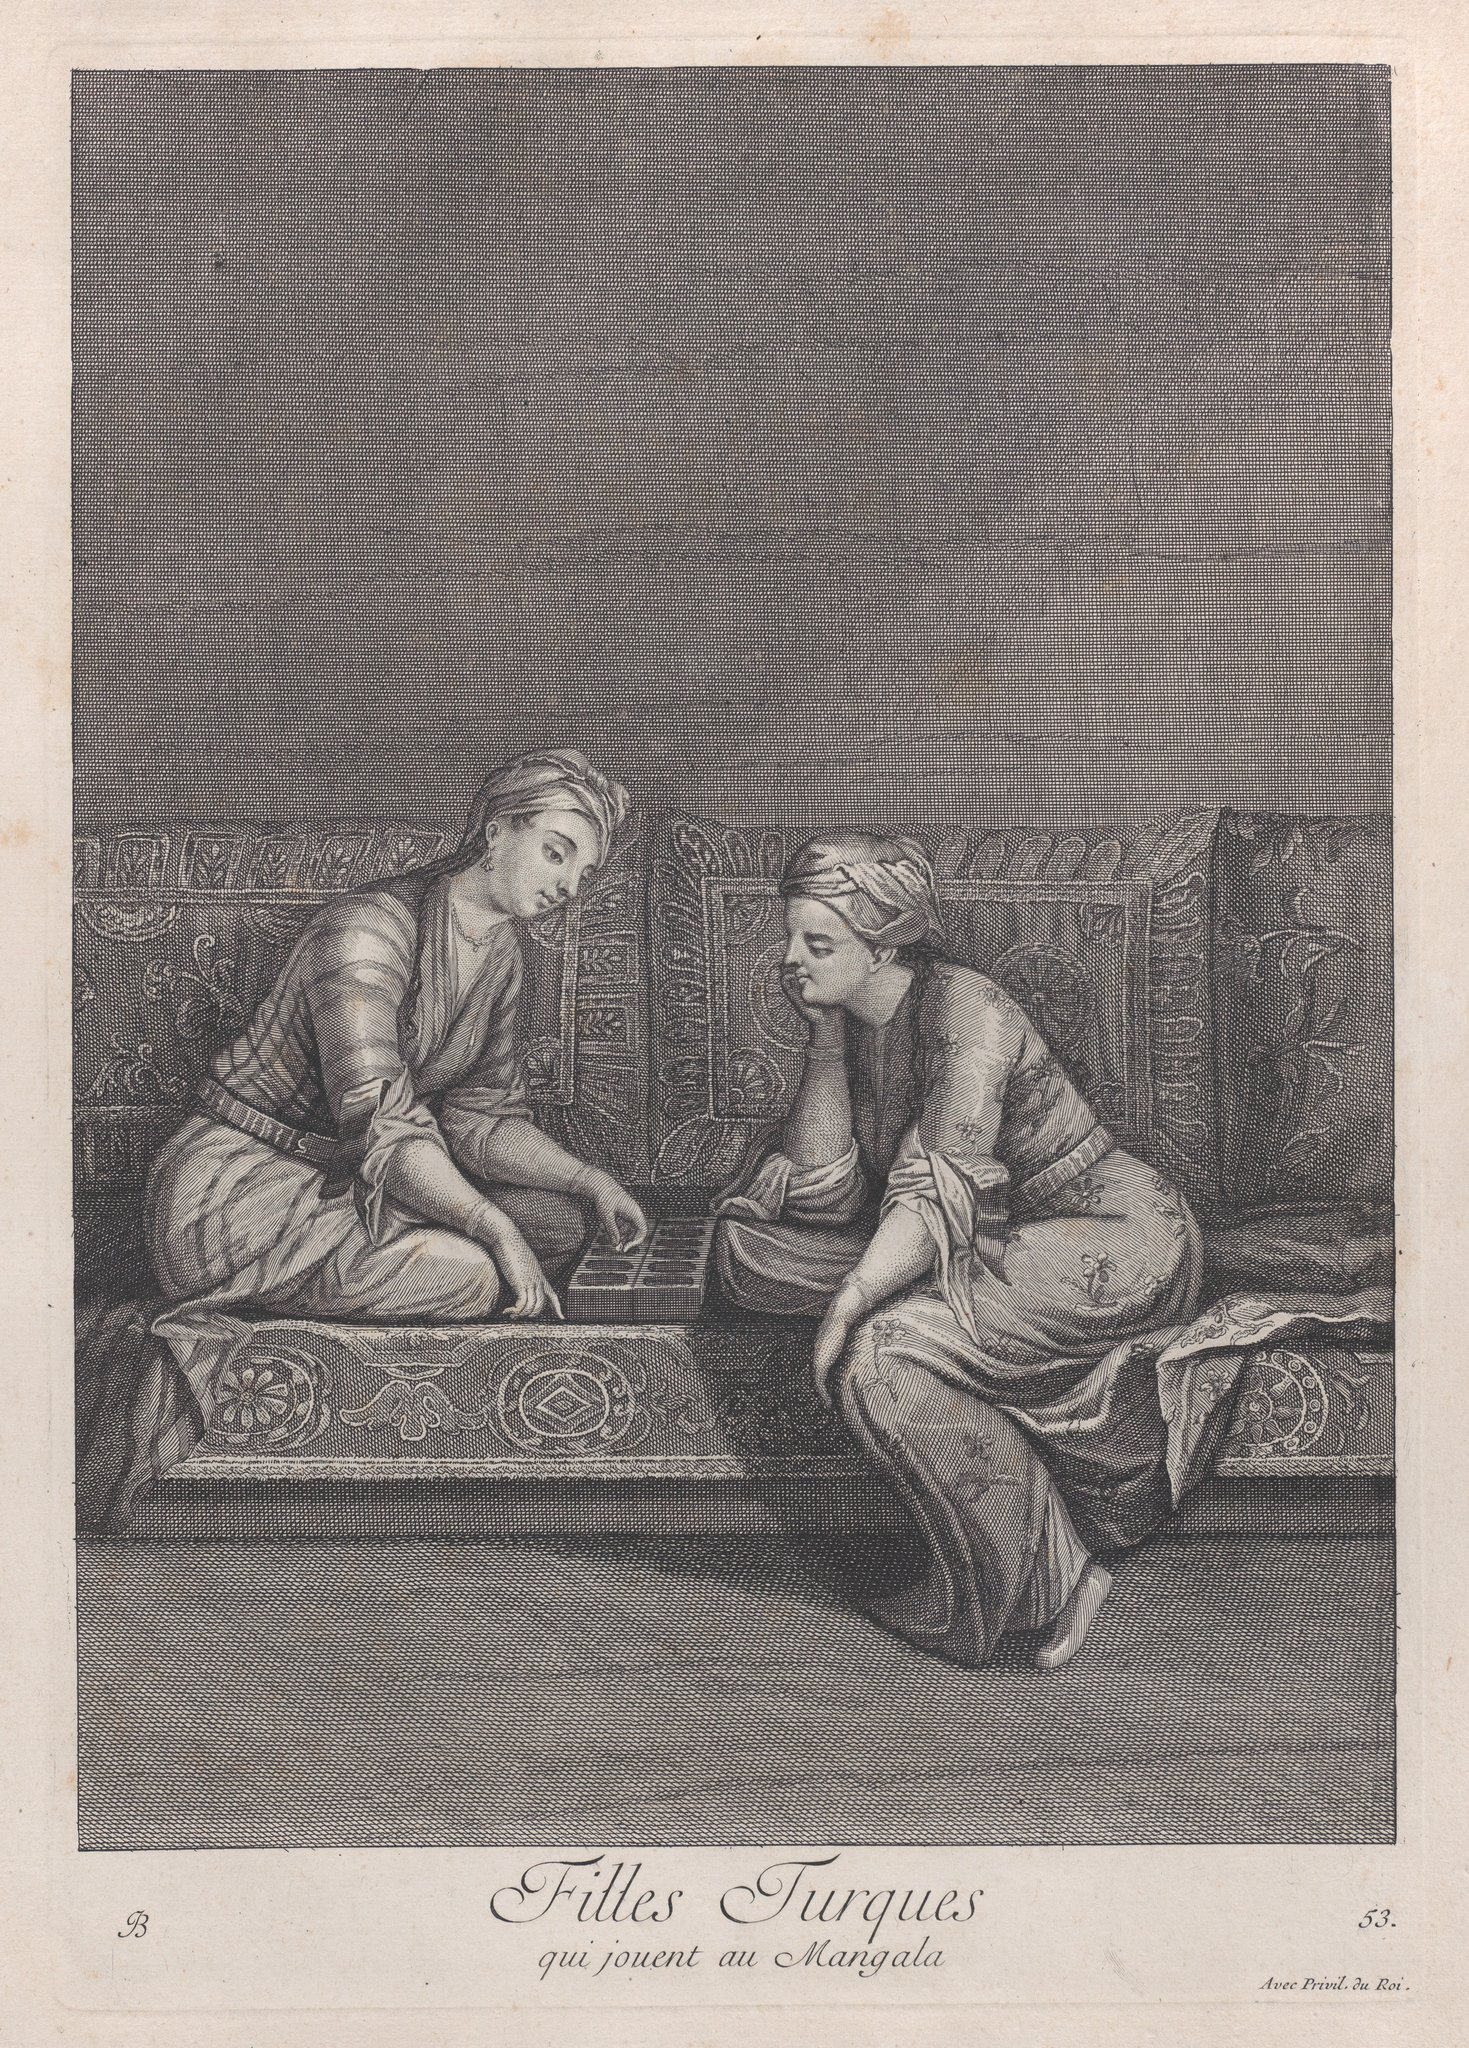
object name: print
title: Filles Turques, qui jouent au Mangala, plate 53 from "Recueil de cent estampes représentent differentes nations du Levant"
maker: jean baptiste vanmour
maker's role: artist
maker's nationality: french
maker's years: 1671-1737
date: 1714-1715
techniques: engraving, etching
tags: women,games